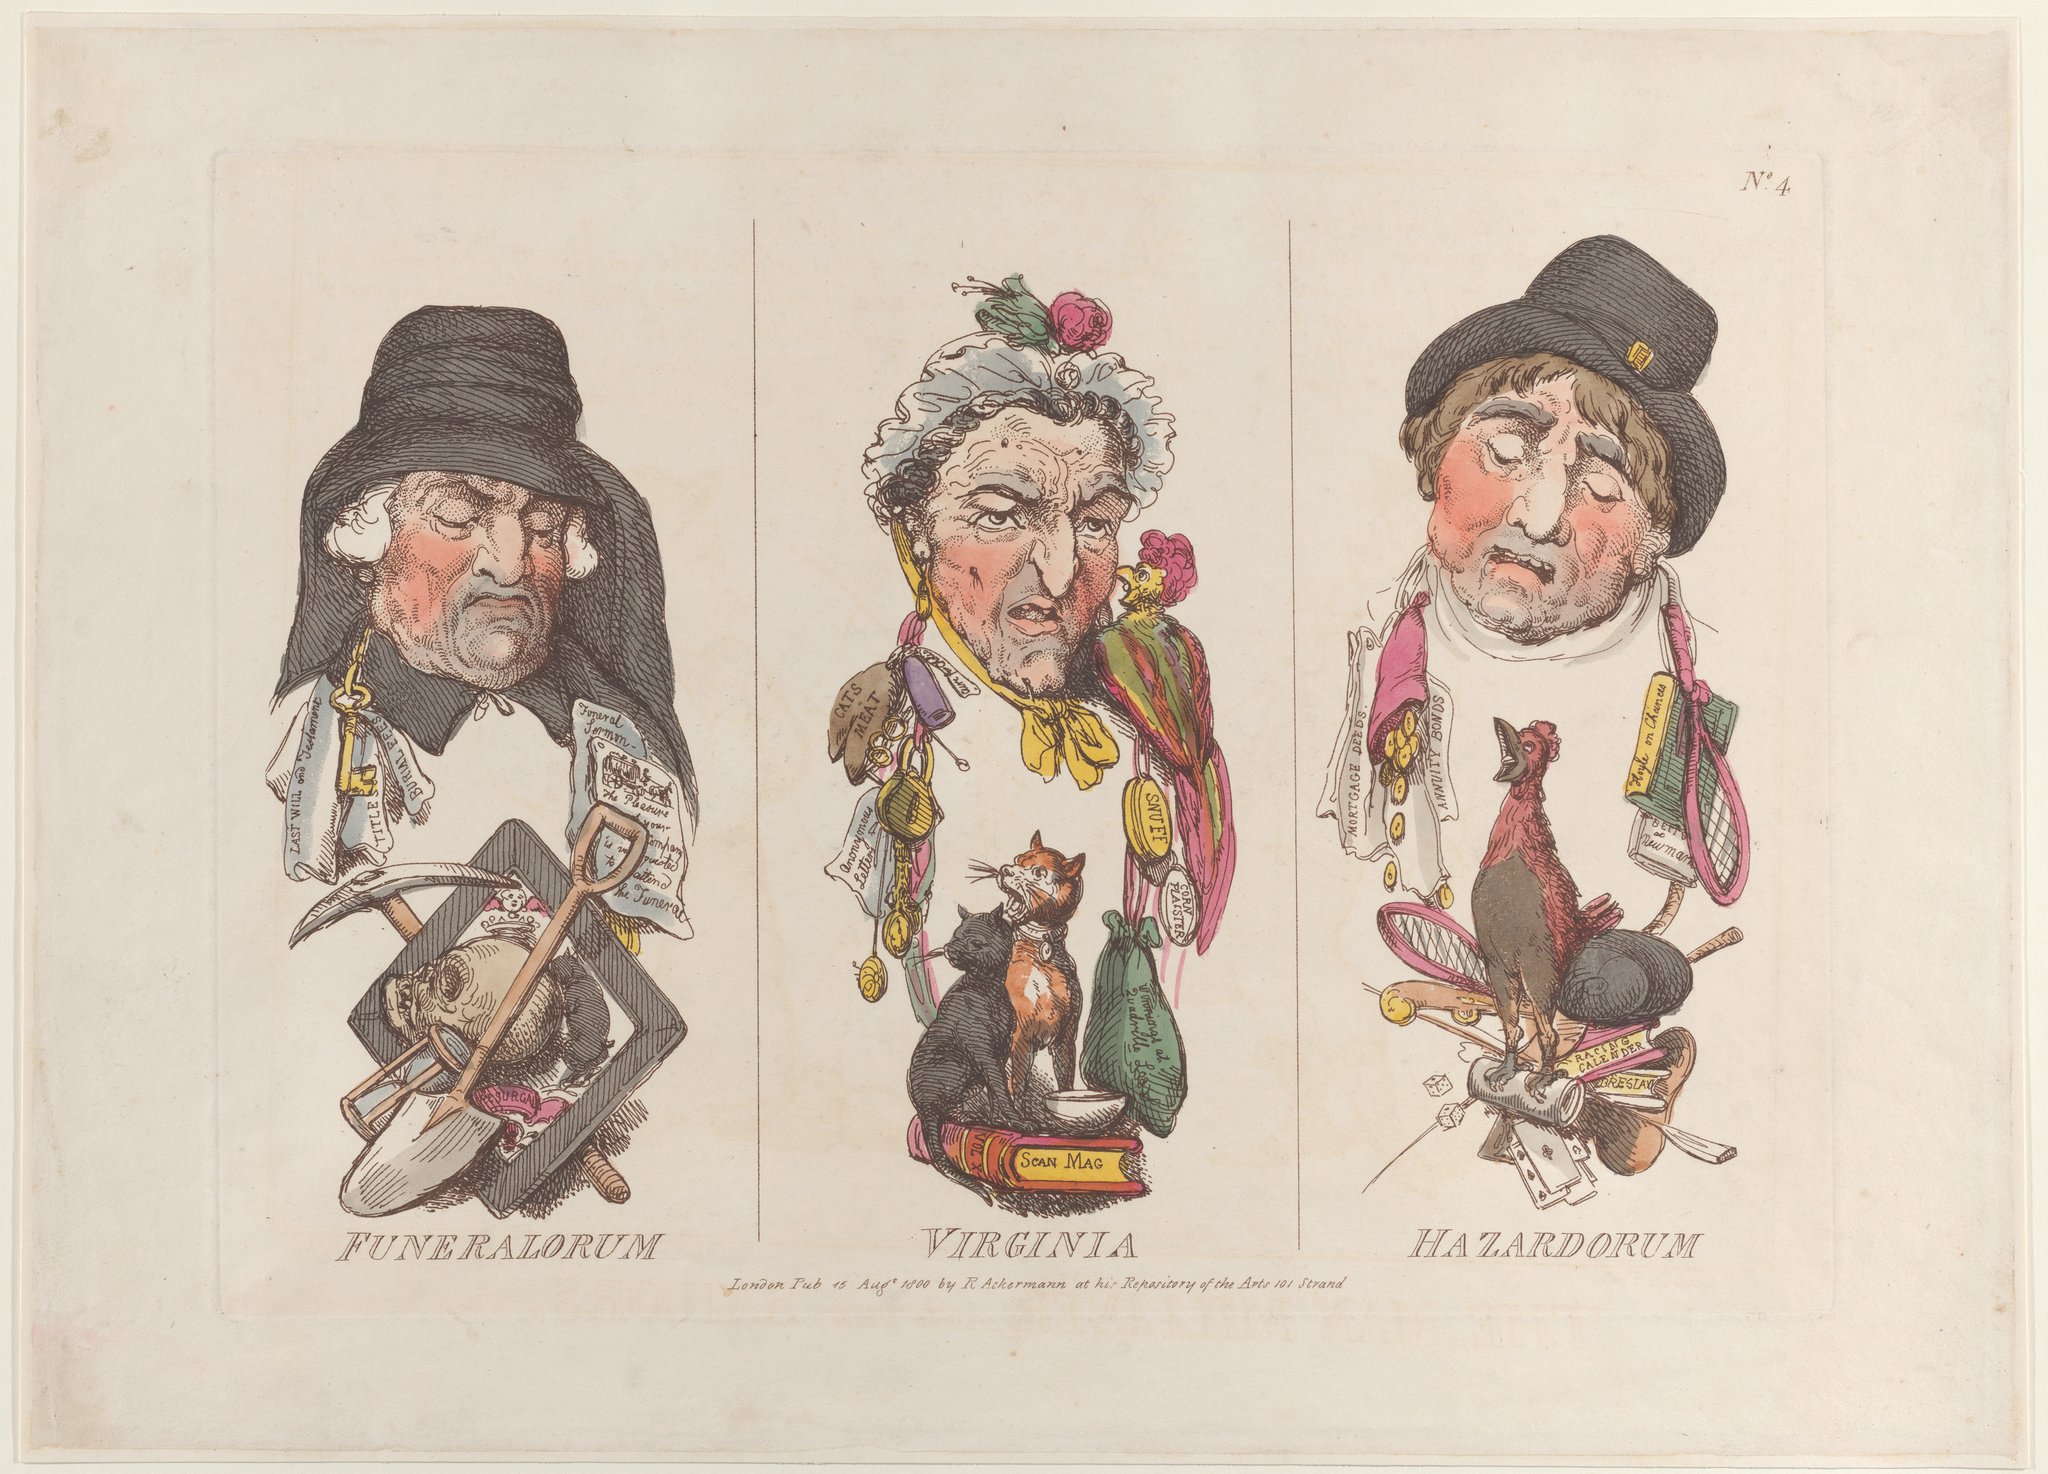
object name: print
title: Funeralorum, Virginia, Hazardorum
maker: thomas rowlandson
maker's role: artist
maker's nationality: british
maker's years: 1757-1827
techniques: etching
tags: satire,men,women,cats